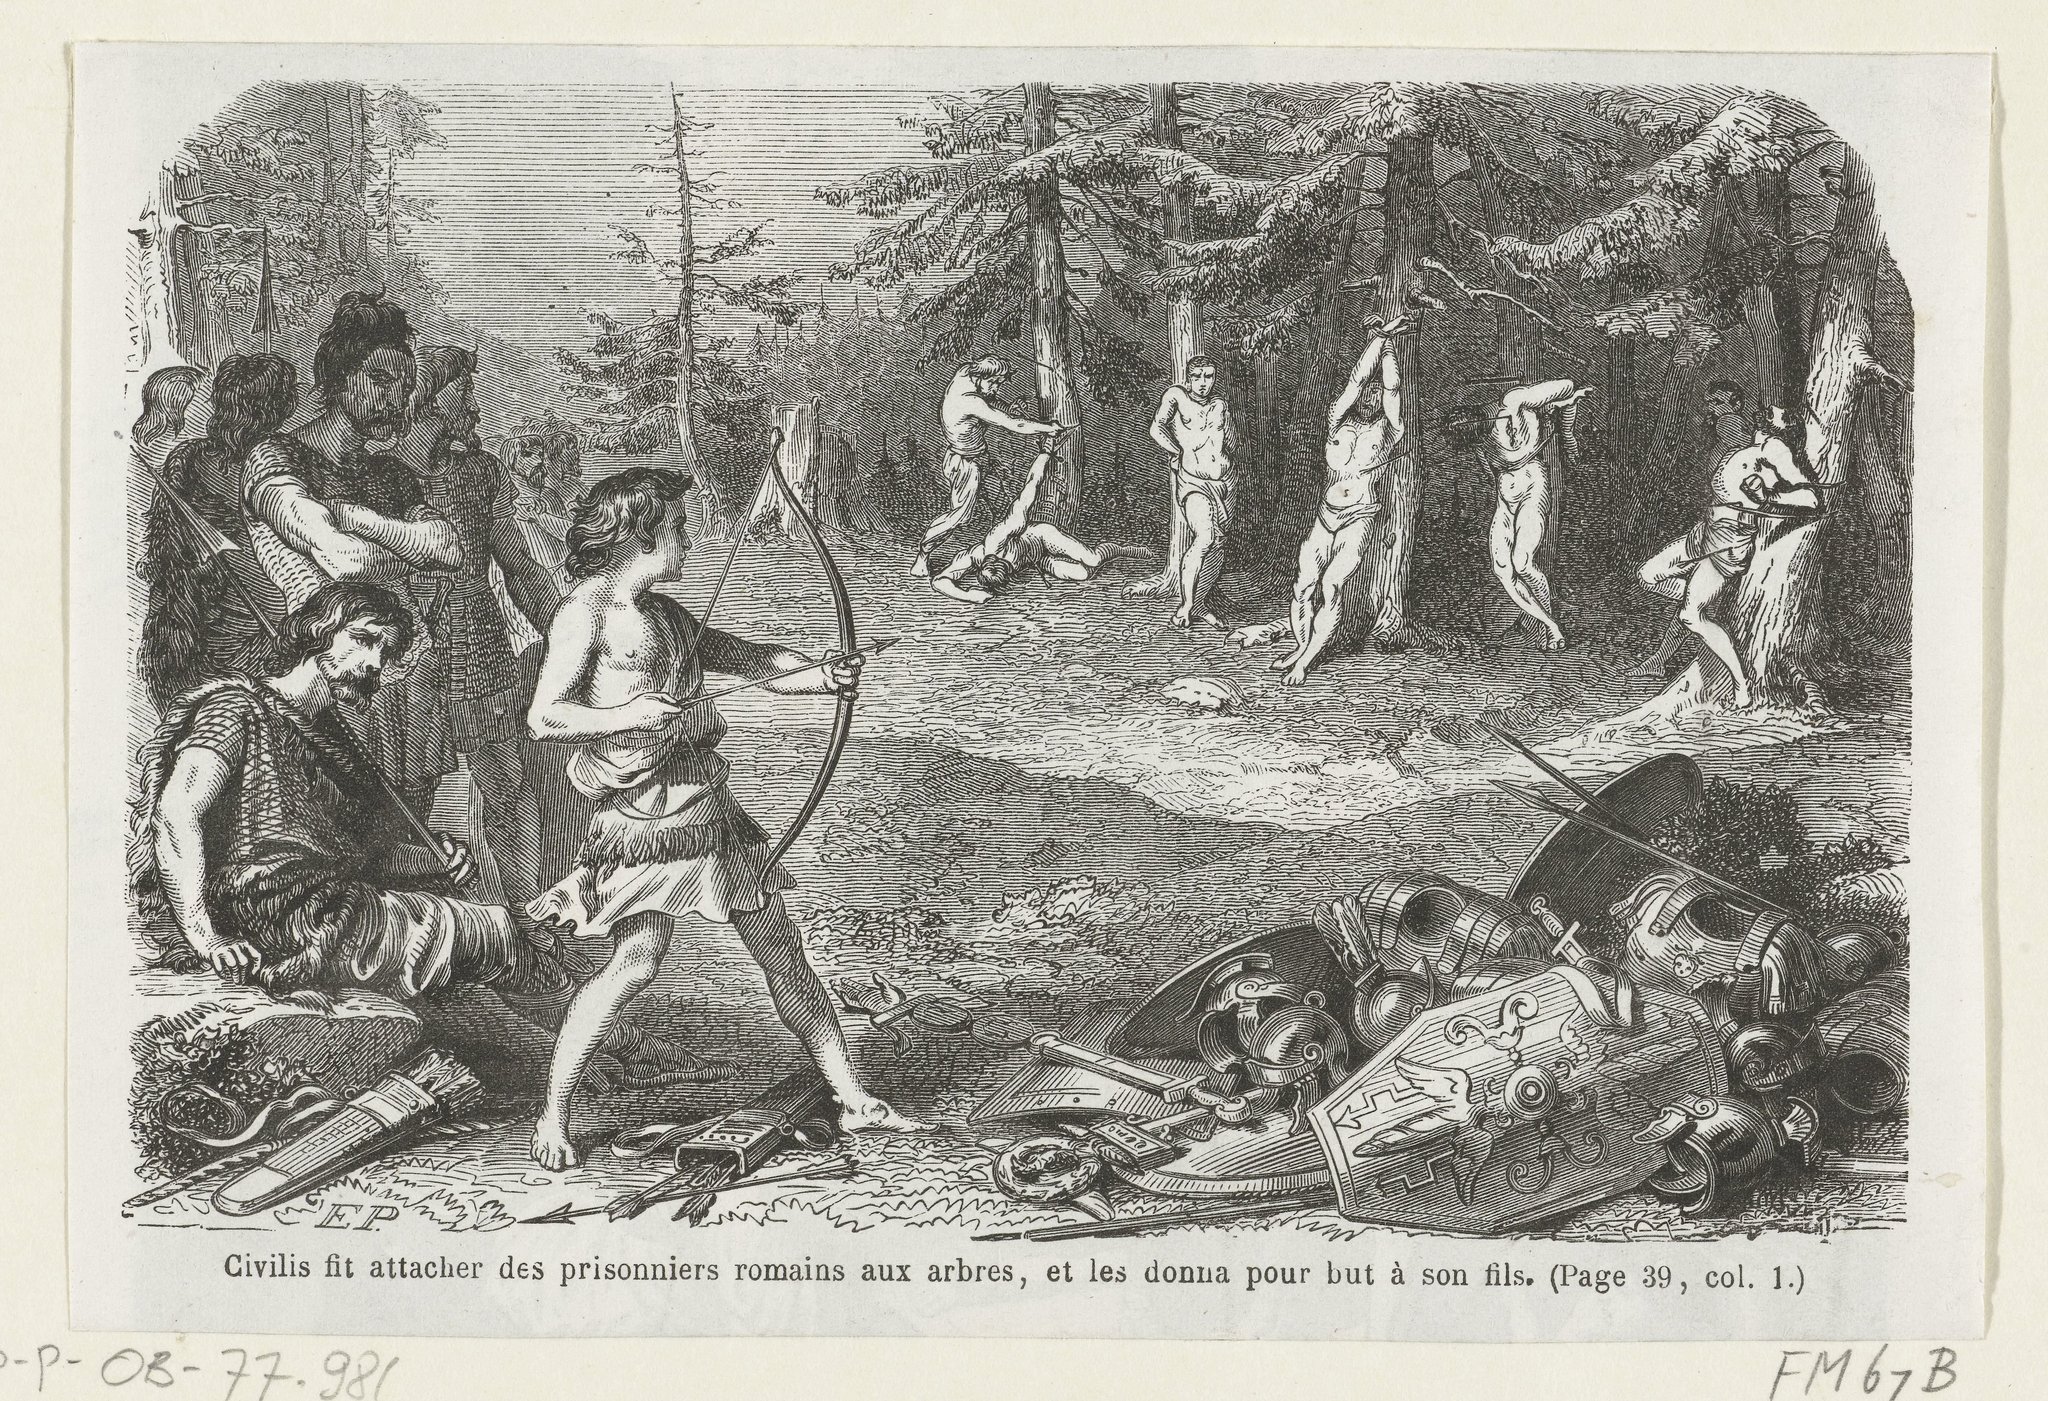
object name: history print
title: Kleinzoon van Civilis schiet op Romeinse gevangenen, 69-70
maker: monogrammist ep (houtgraveur)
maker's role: print maker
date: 1800-1899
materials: paper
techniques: engraving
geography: france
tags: extinct, 'historical' peoples (with name), netherlands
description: Illustratie uit een Franstalige boek of tijdschrift geknipt. Niet in Frederik Muller; door het RPK toegevoegd nummer.